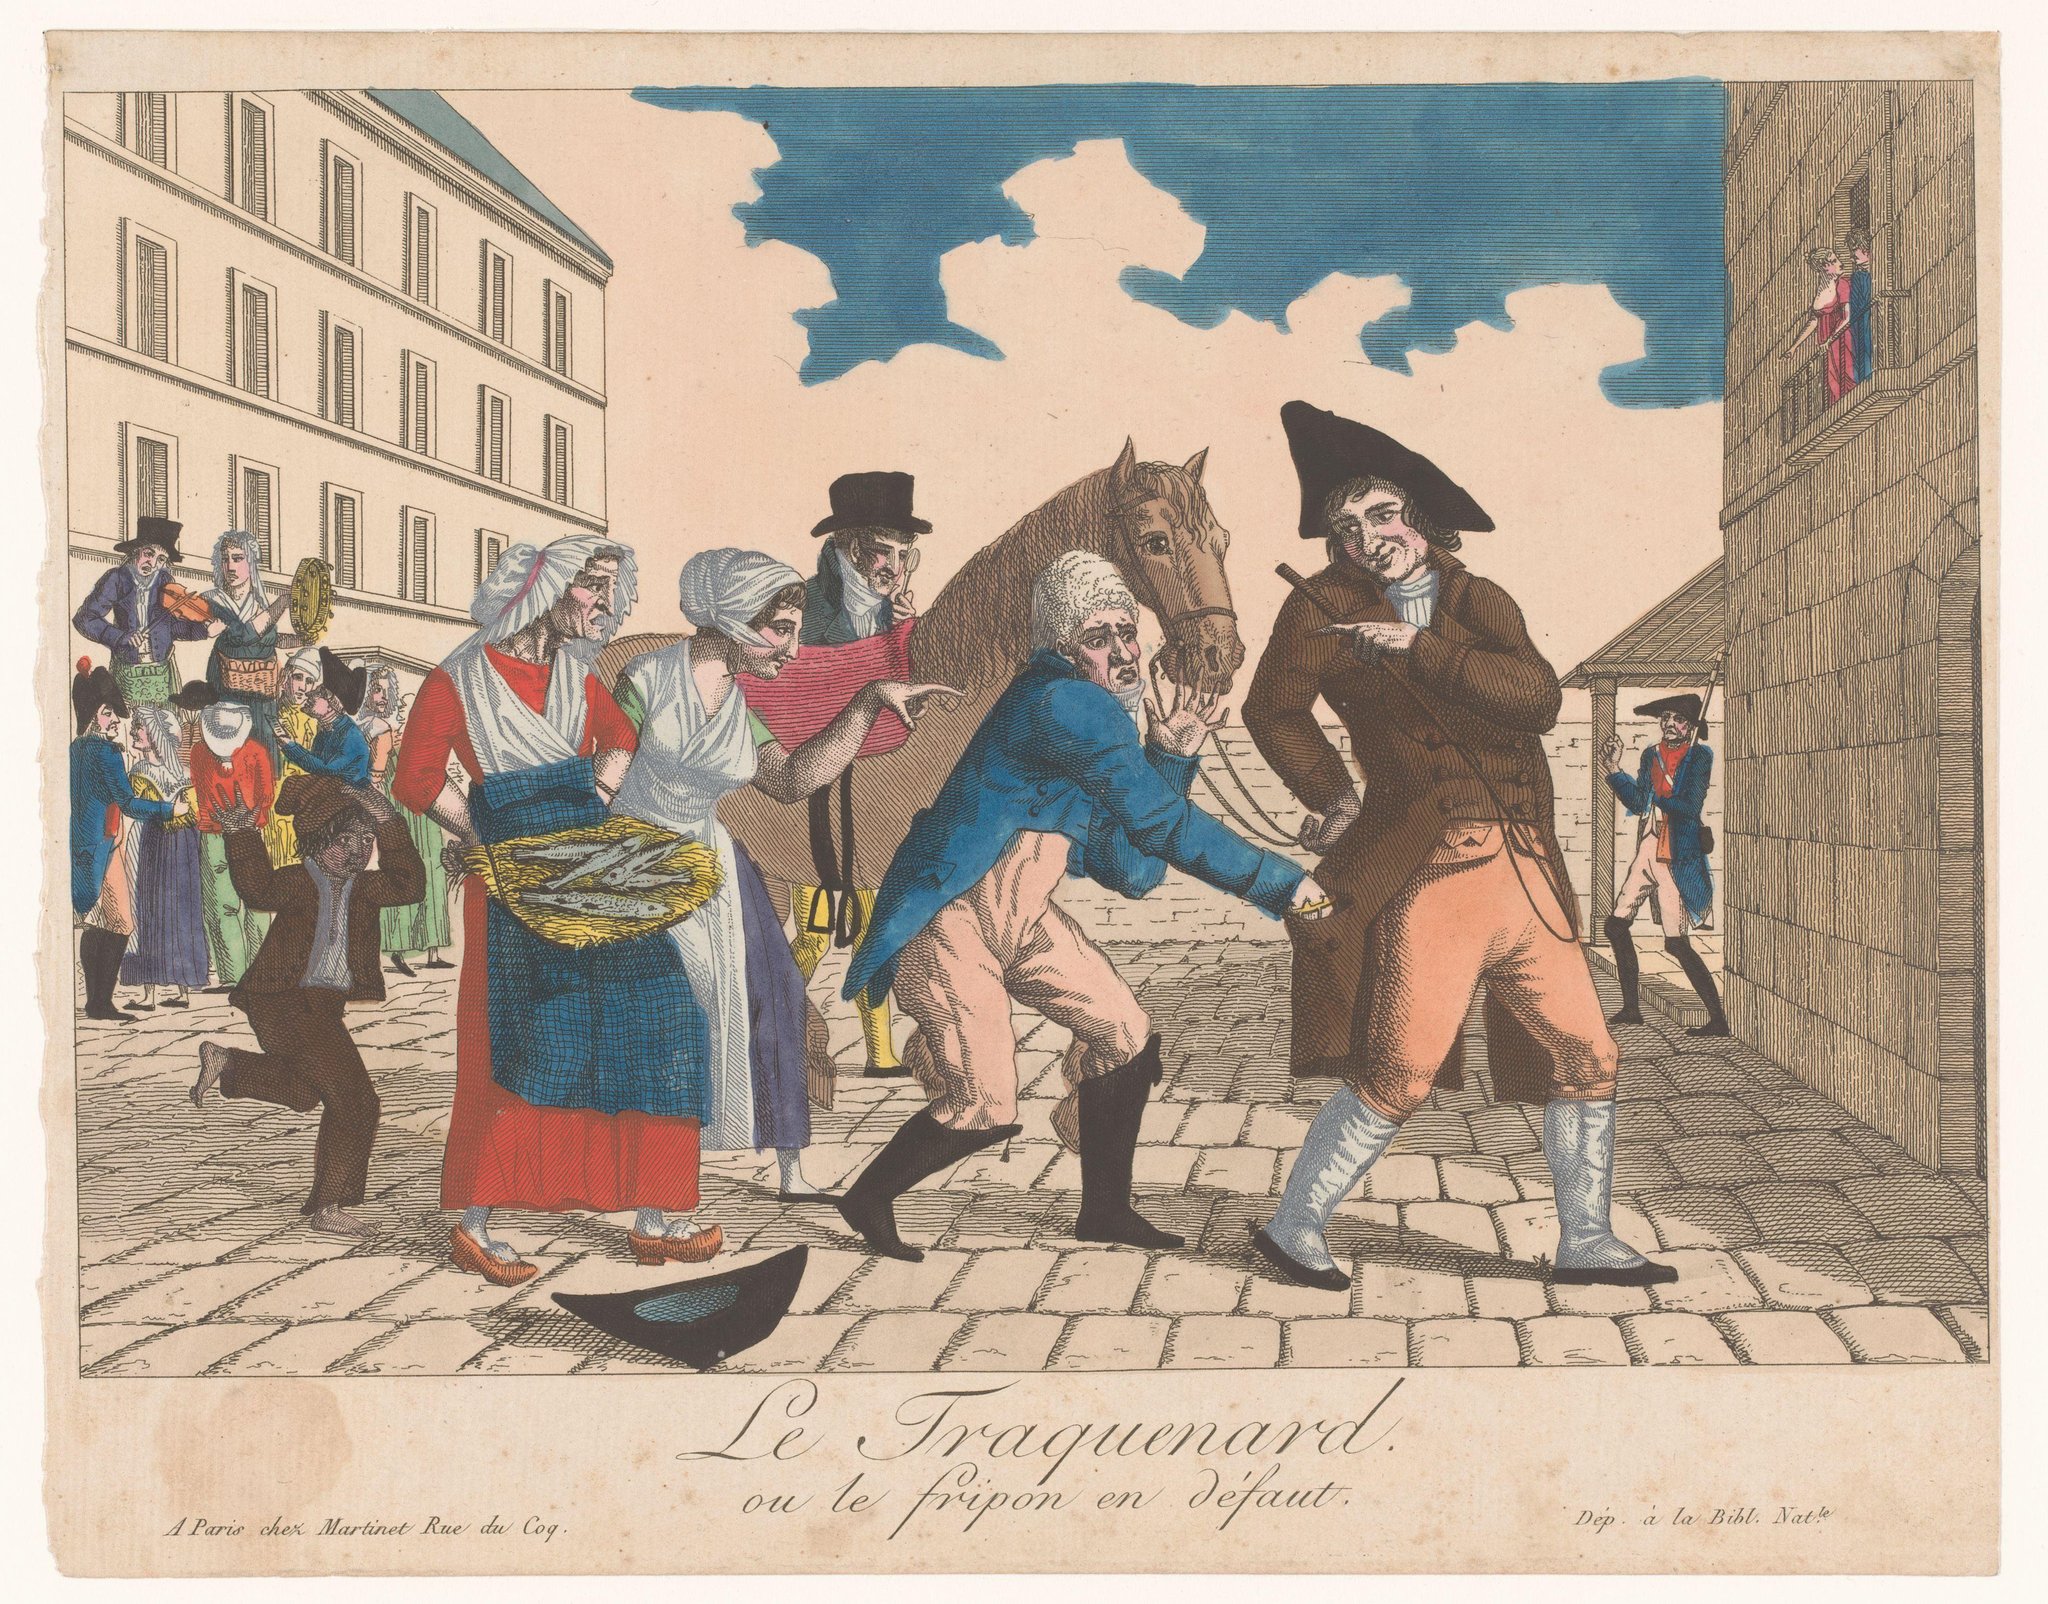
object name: print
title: De valstrik ofwel de falende boef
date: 1796-1824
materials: paper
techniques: engraving, etching, hand coloring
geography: paris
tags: square, place, circus, etc., crowd, mob, robber, leading a horse by the reins; rider beside his horse, pitfalls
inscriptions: collector's mark: Lugt 2228, collector's mark: Lugt 1060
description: Een zakkenroller wordt betrapt als hij in een opzettelijk geplaatste klem grijpt in de jaszak van zijn slachtoffer. Het slachtoffer kijkt hem lachend aan, twee vrouwen zijn getuige.